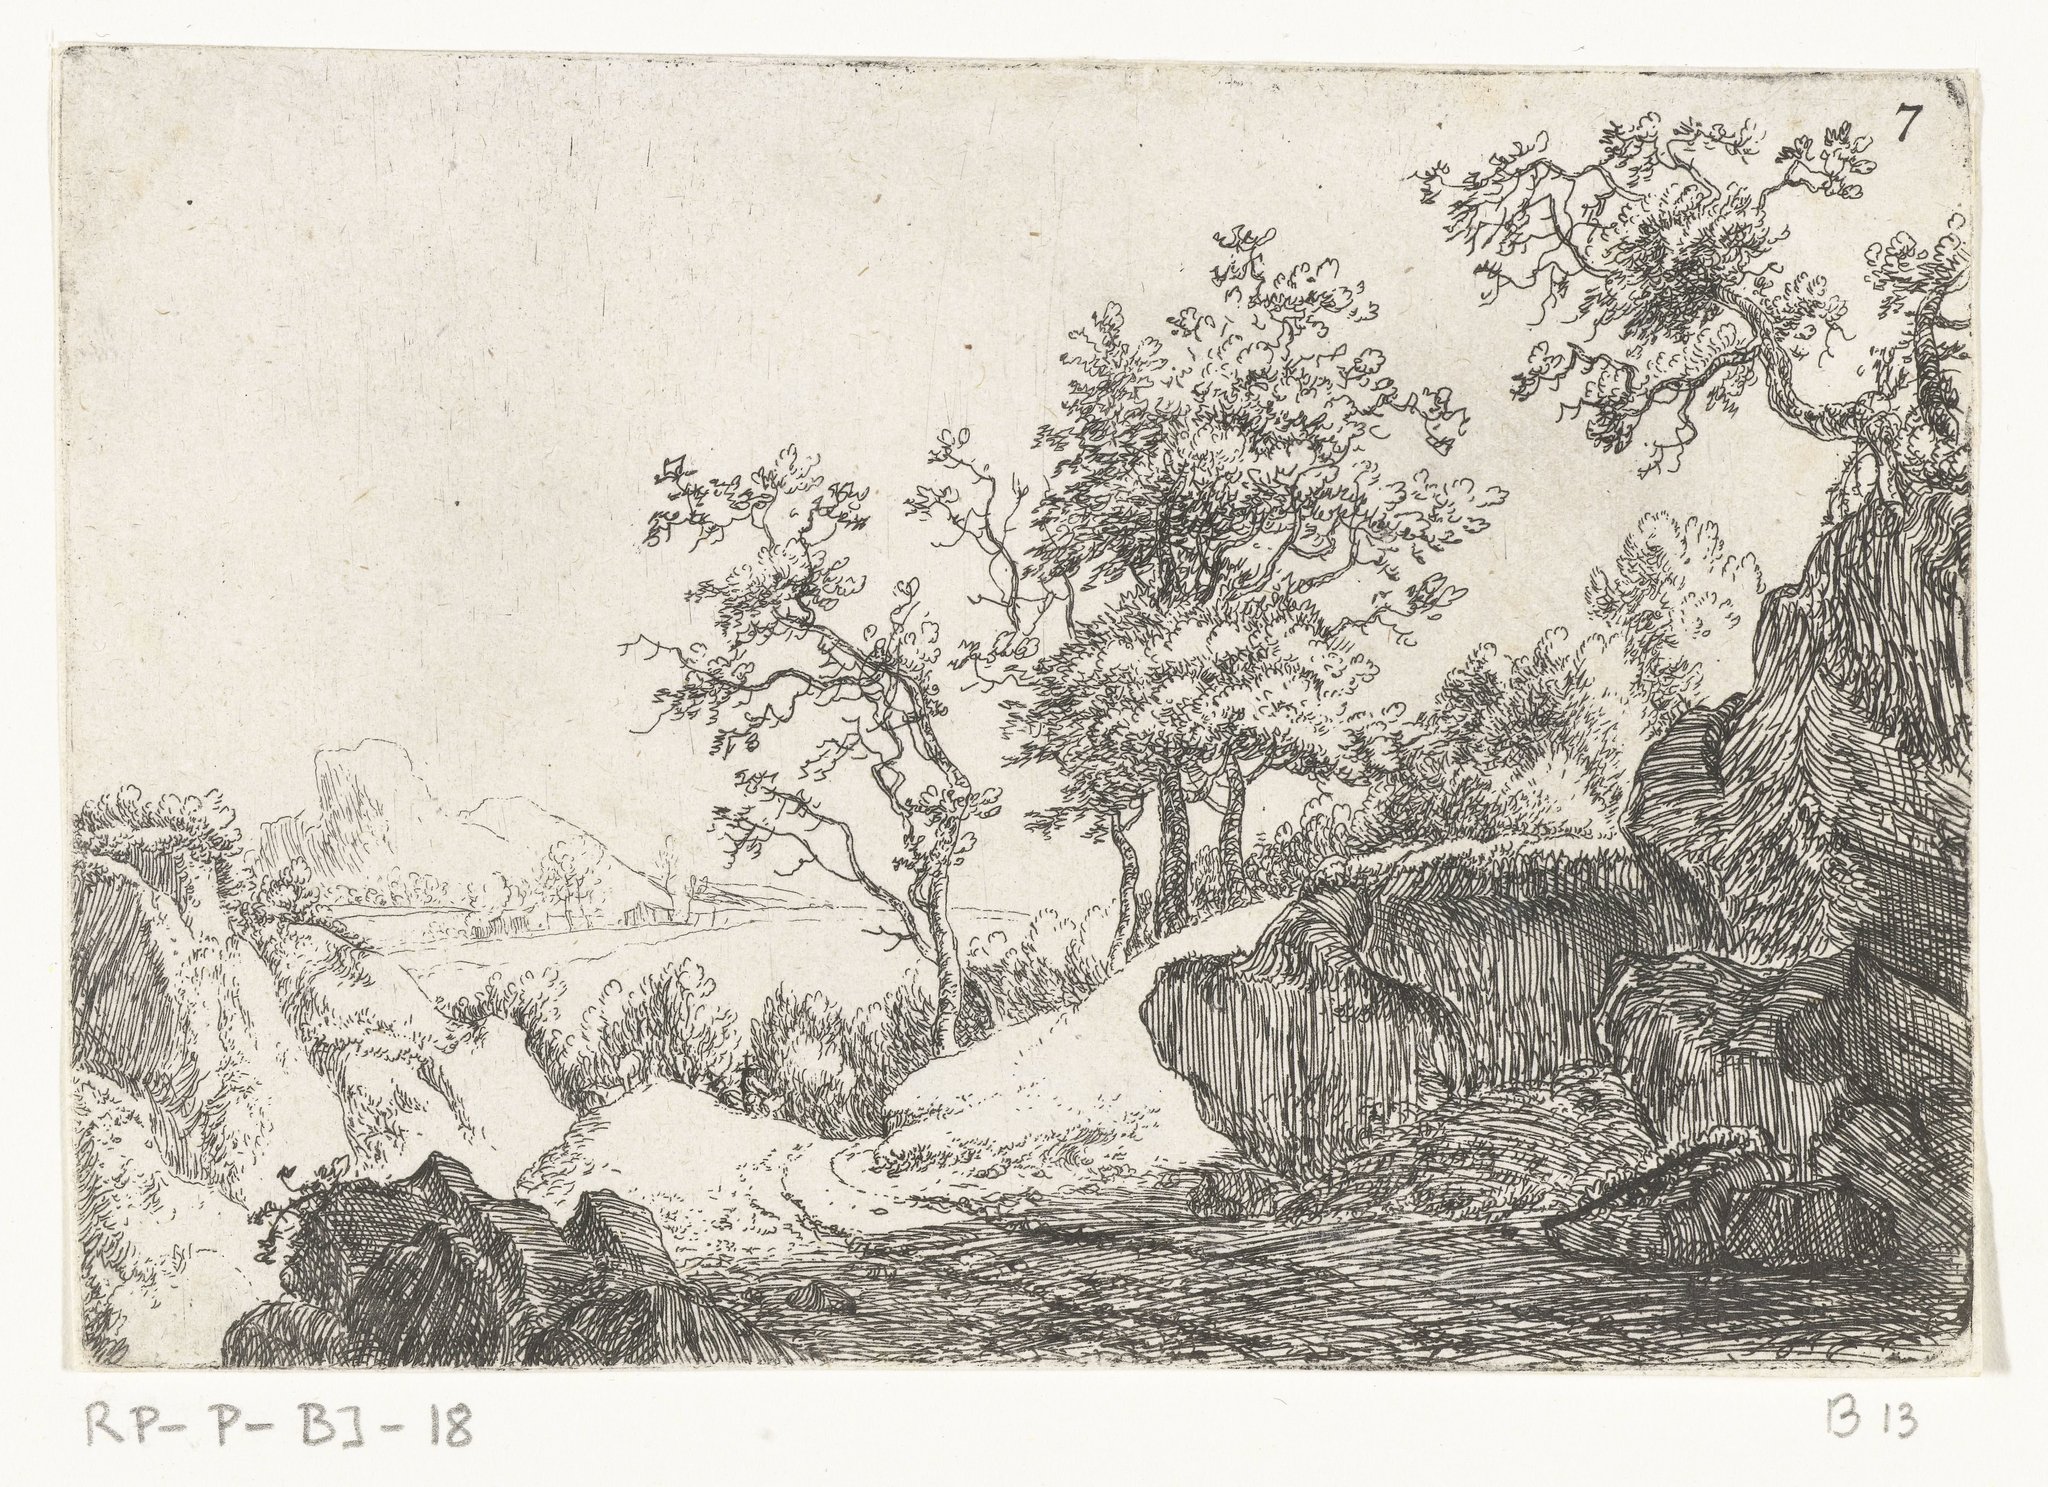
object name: print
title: Heuvelachtig landschap met bomen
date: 1624-1661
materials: paper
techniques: etching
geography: amsterdam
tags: landscapes in the temperate zone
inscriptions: collector's mark: Lugt 240